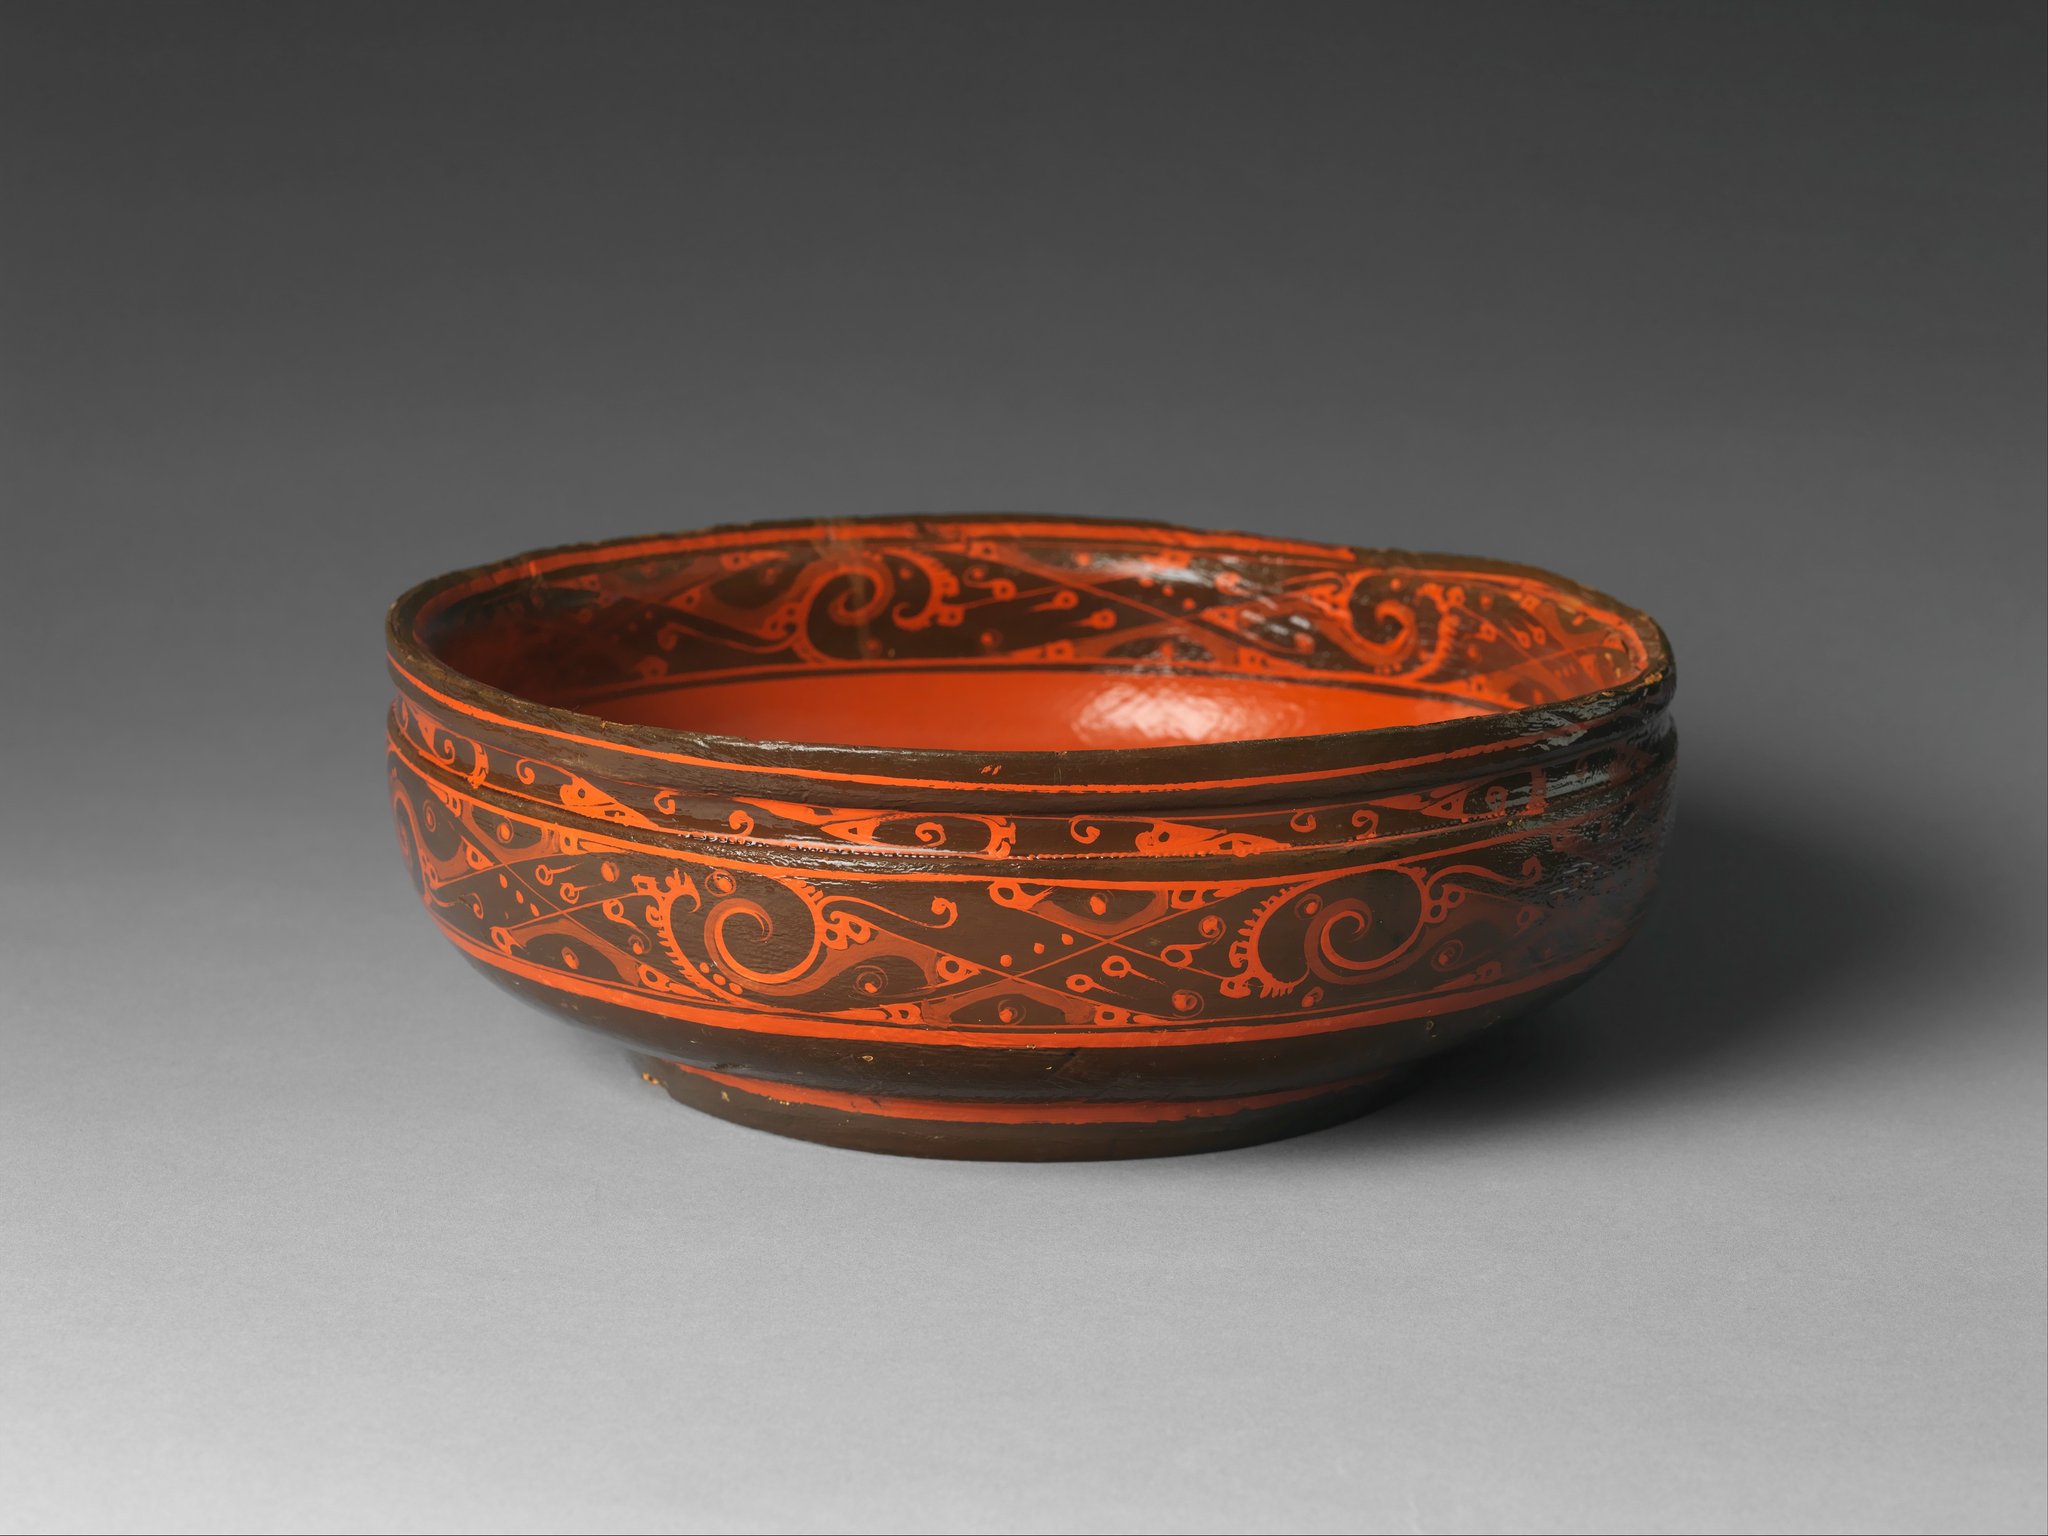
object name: bowl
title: Bowl with Geometric Designs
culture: chinese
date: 200-101 BCE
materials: lacquer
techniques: painting